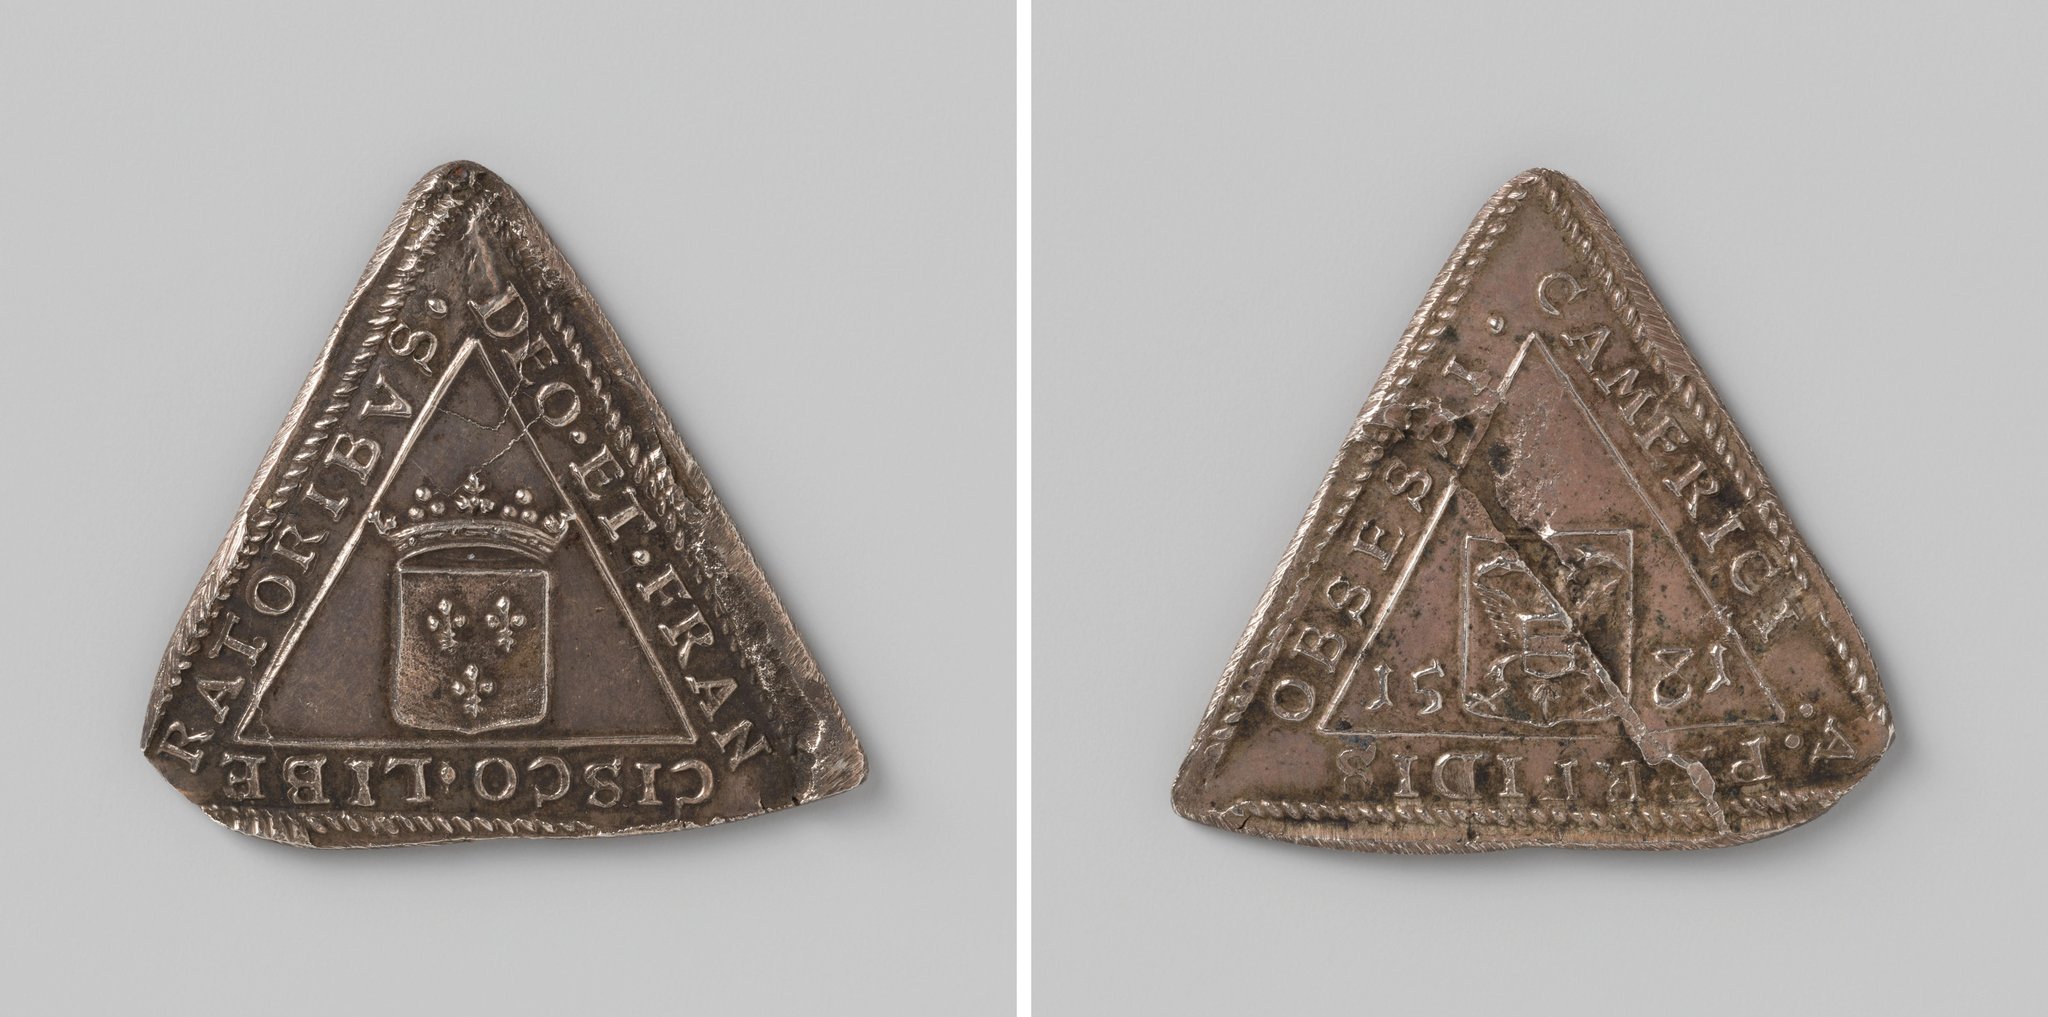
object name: medal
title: Ter ere van de hertog van Anjou, als dank voor het ontzet van Kamerijk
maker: Anonymous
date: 1581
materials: silver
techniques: striking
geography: cambrai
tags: paris, françois-hercule de valois (hertog van anjou)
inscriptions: inscription: ‘DEO . ET . FRAN / CISCO . LIBE / RATORIBVS .’, inscription: ‘15 - 81 / CAMERICI . / A / . PERFIDIS / OBSESSI .’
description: driehoekige penning. Voorzijde: gekroond wapenschild binnen omschrift. Keerzijde: wapenschild binnen omschrift